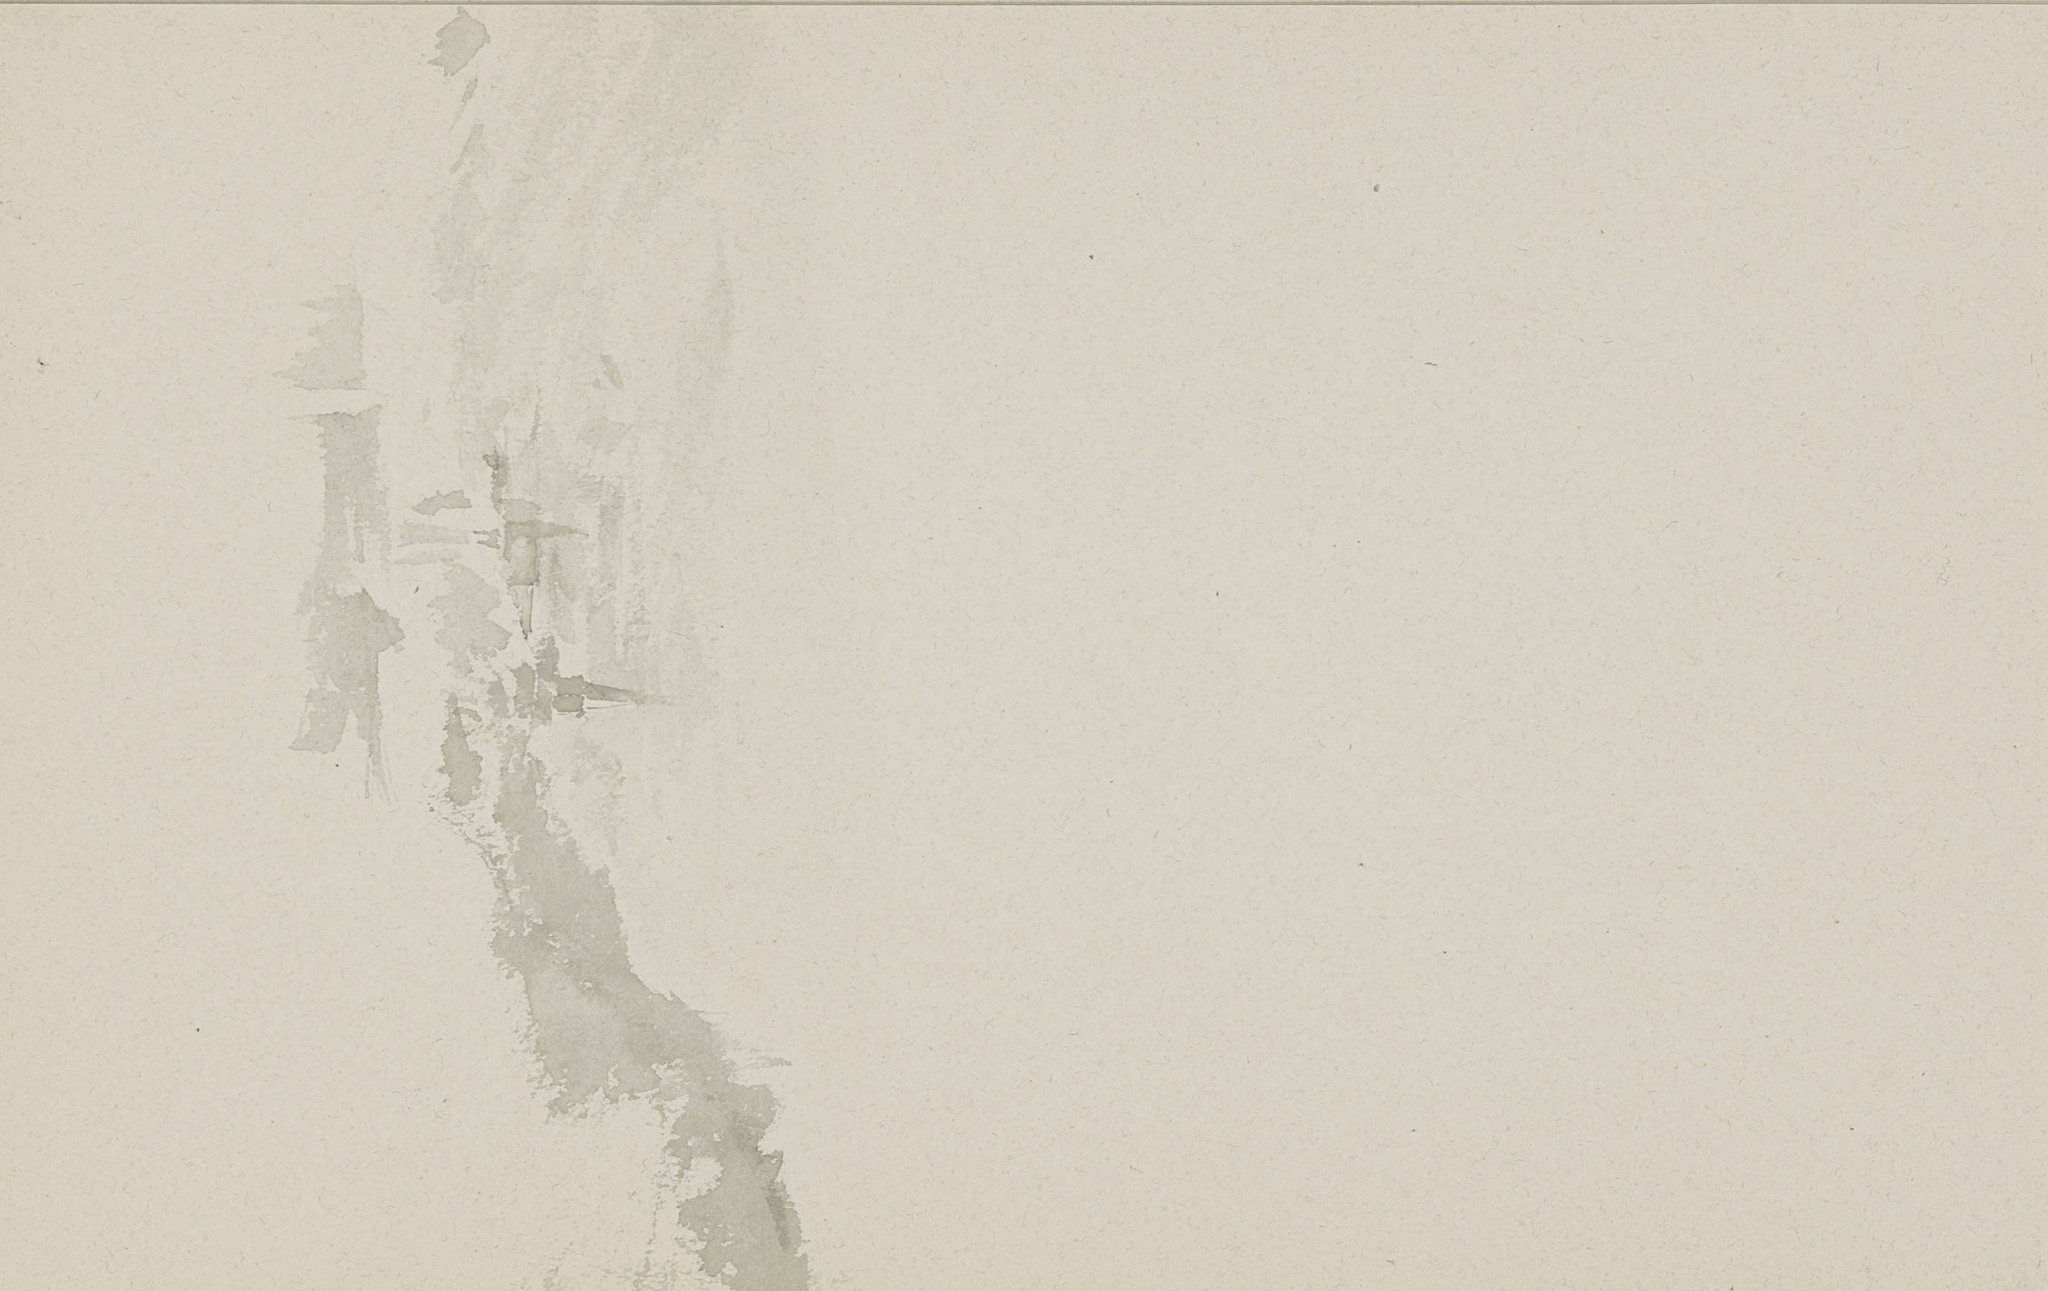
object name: sketchbook leaf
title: Gezicht op een stad met een kerktoren in de bergen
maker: a.a.l. de grammont-hubrecht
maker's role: draughtsman, painter, print maker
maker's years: 1855-1913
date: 1865-1913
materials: paper, watercolor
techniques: brush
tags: city-view, and landscape with man-made constructions, church (exterior), mountains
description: Blad 56 verso uit een schetsboek met 65 bladen.